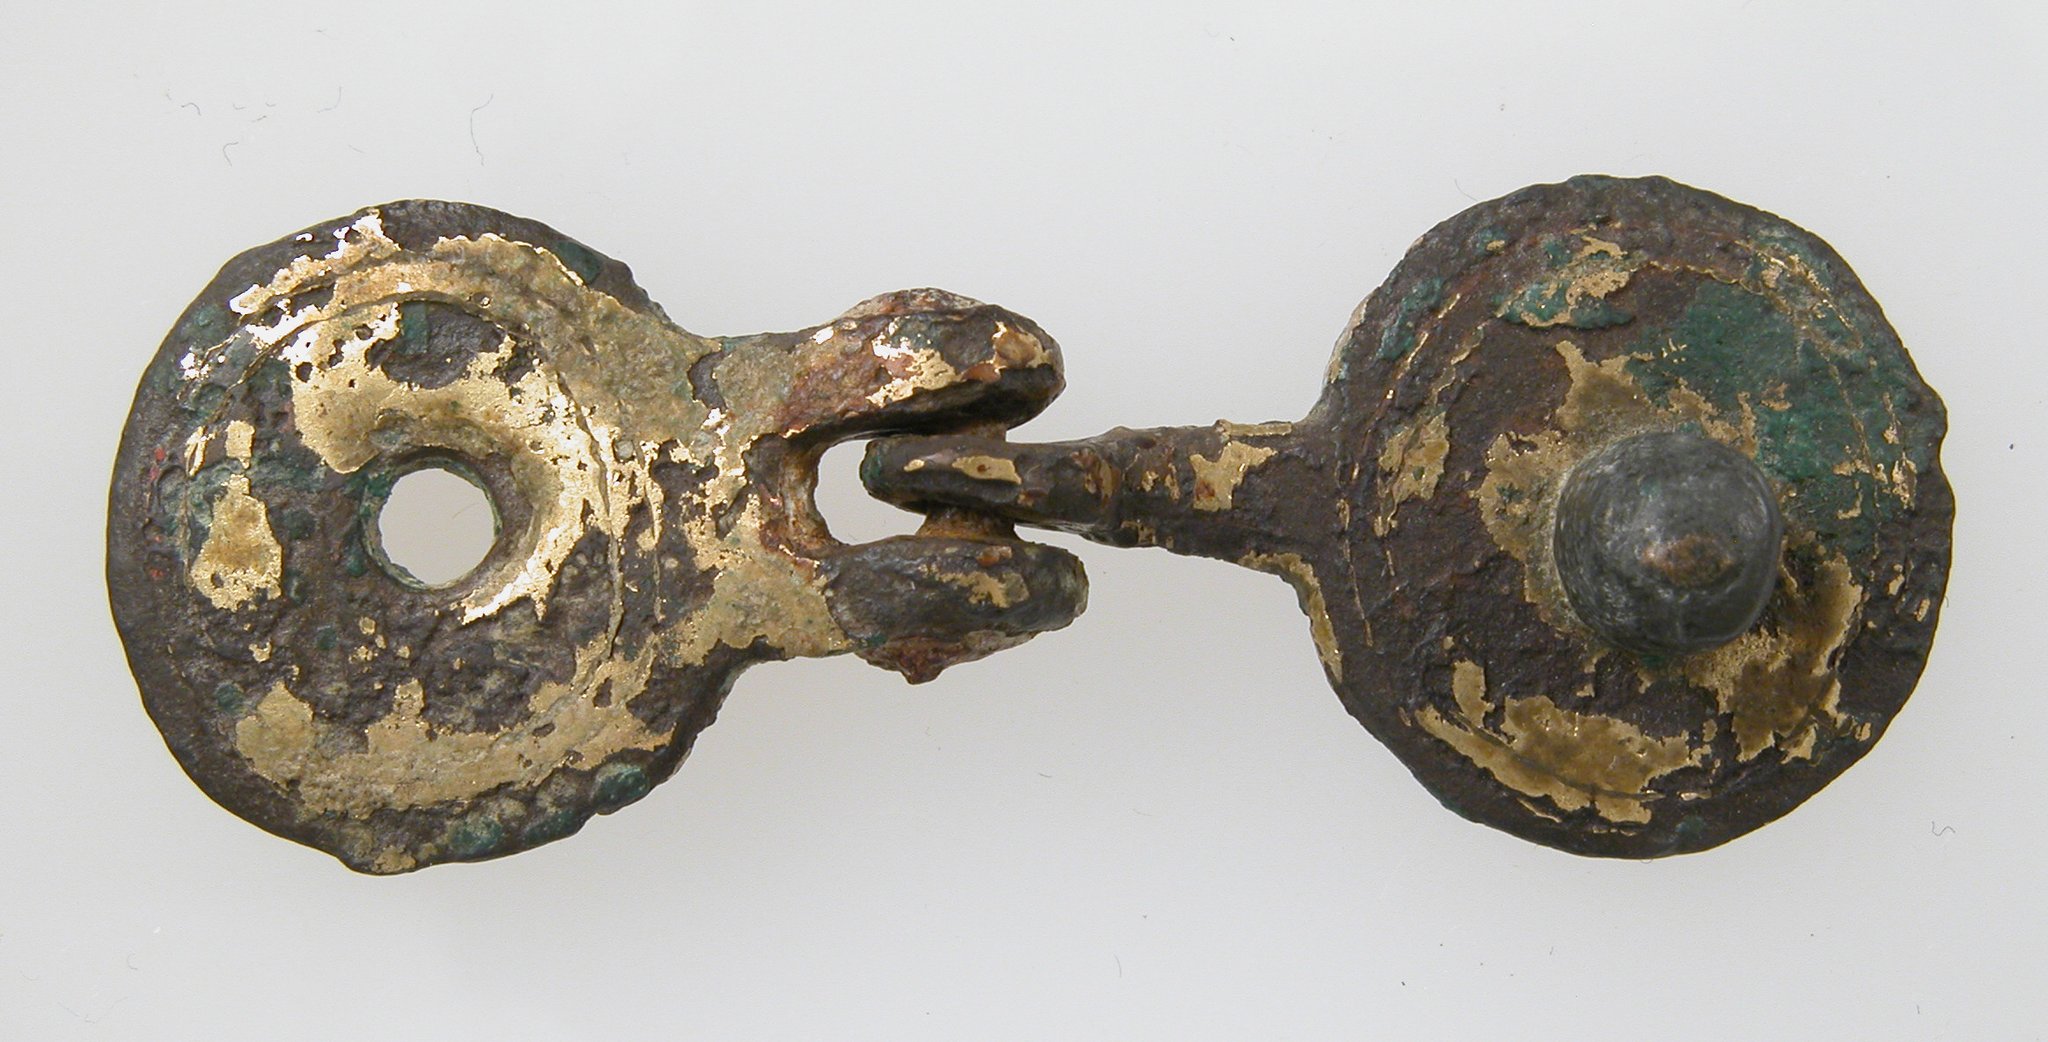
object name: implement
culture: frankish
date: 500-700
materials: bronze, gilt